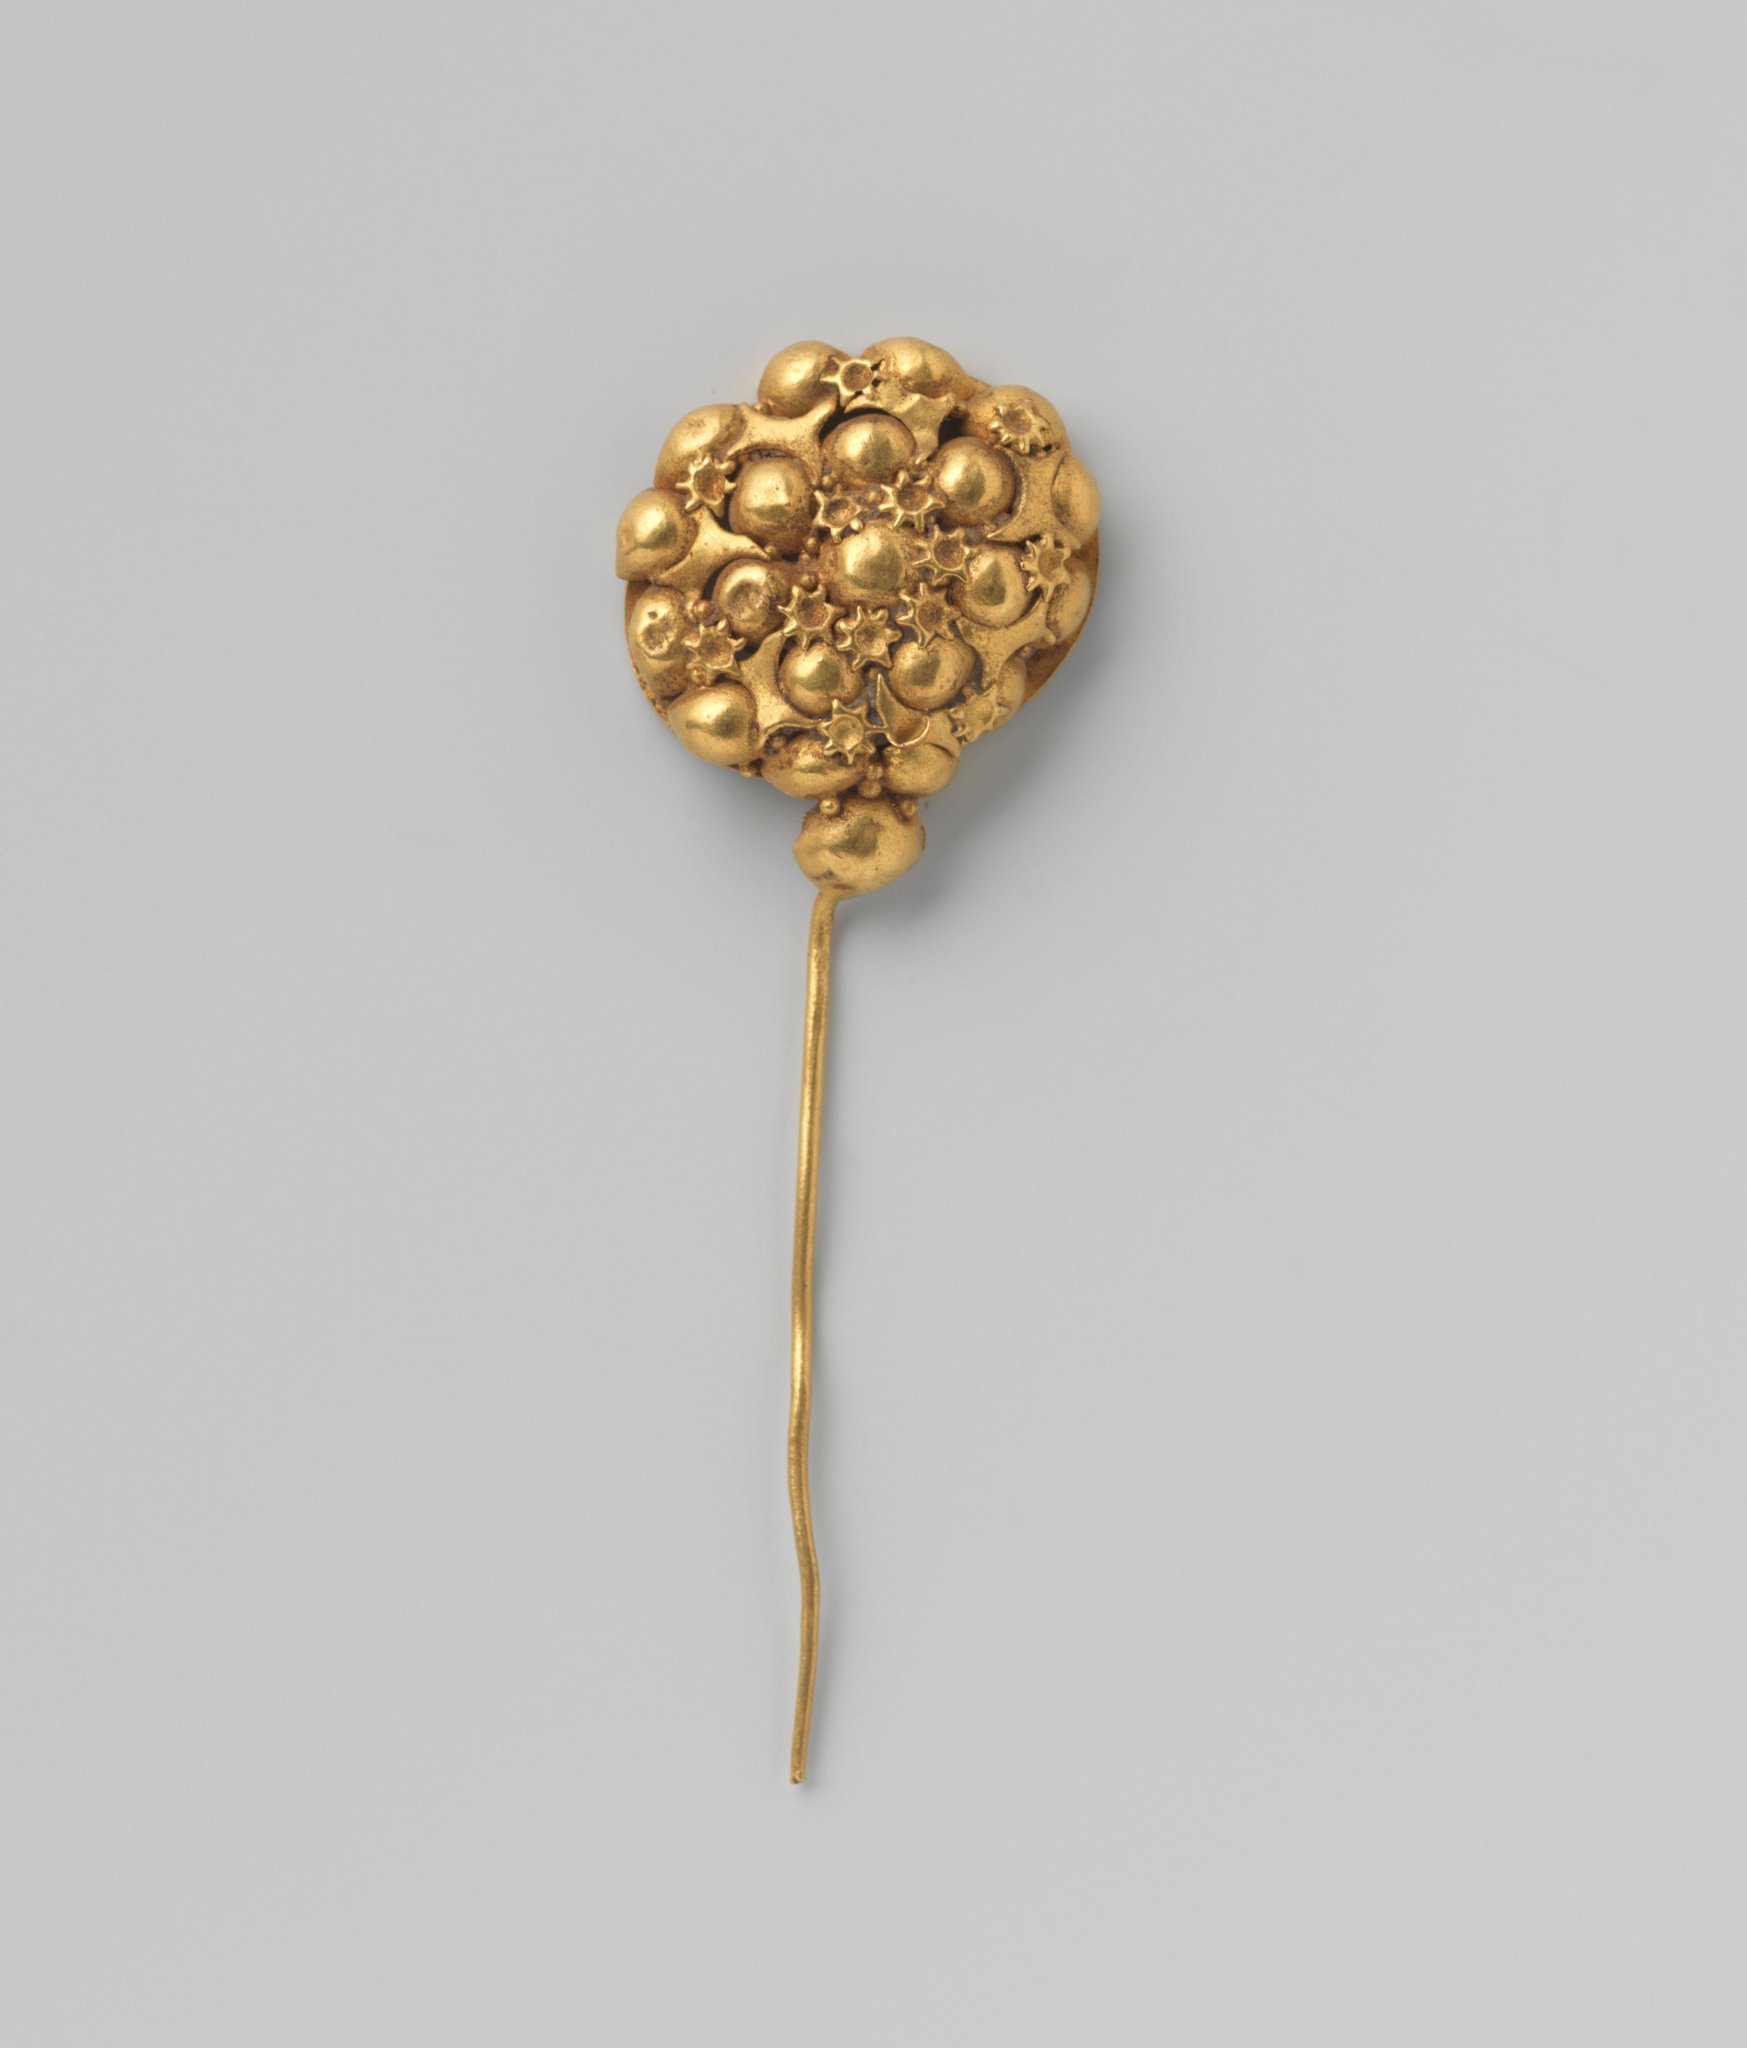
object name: jewellery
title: Speld van goud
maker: Anonymous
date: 1600-1699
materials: gold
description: Bovenop de speld een ronde gebobbelde knop.